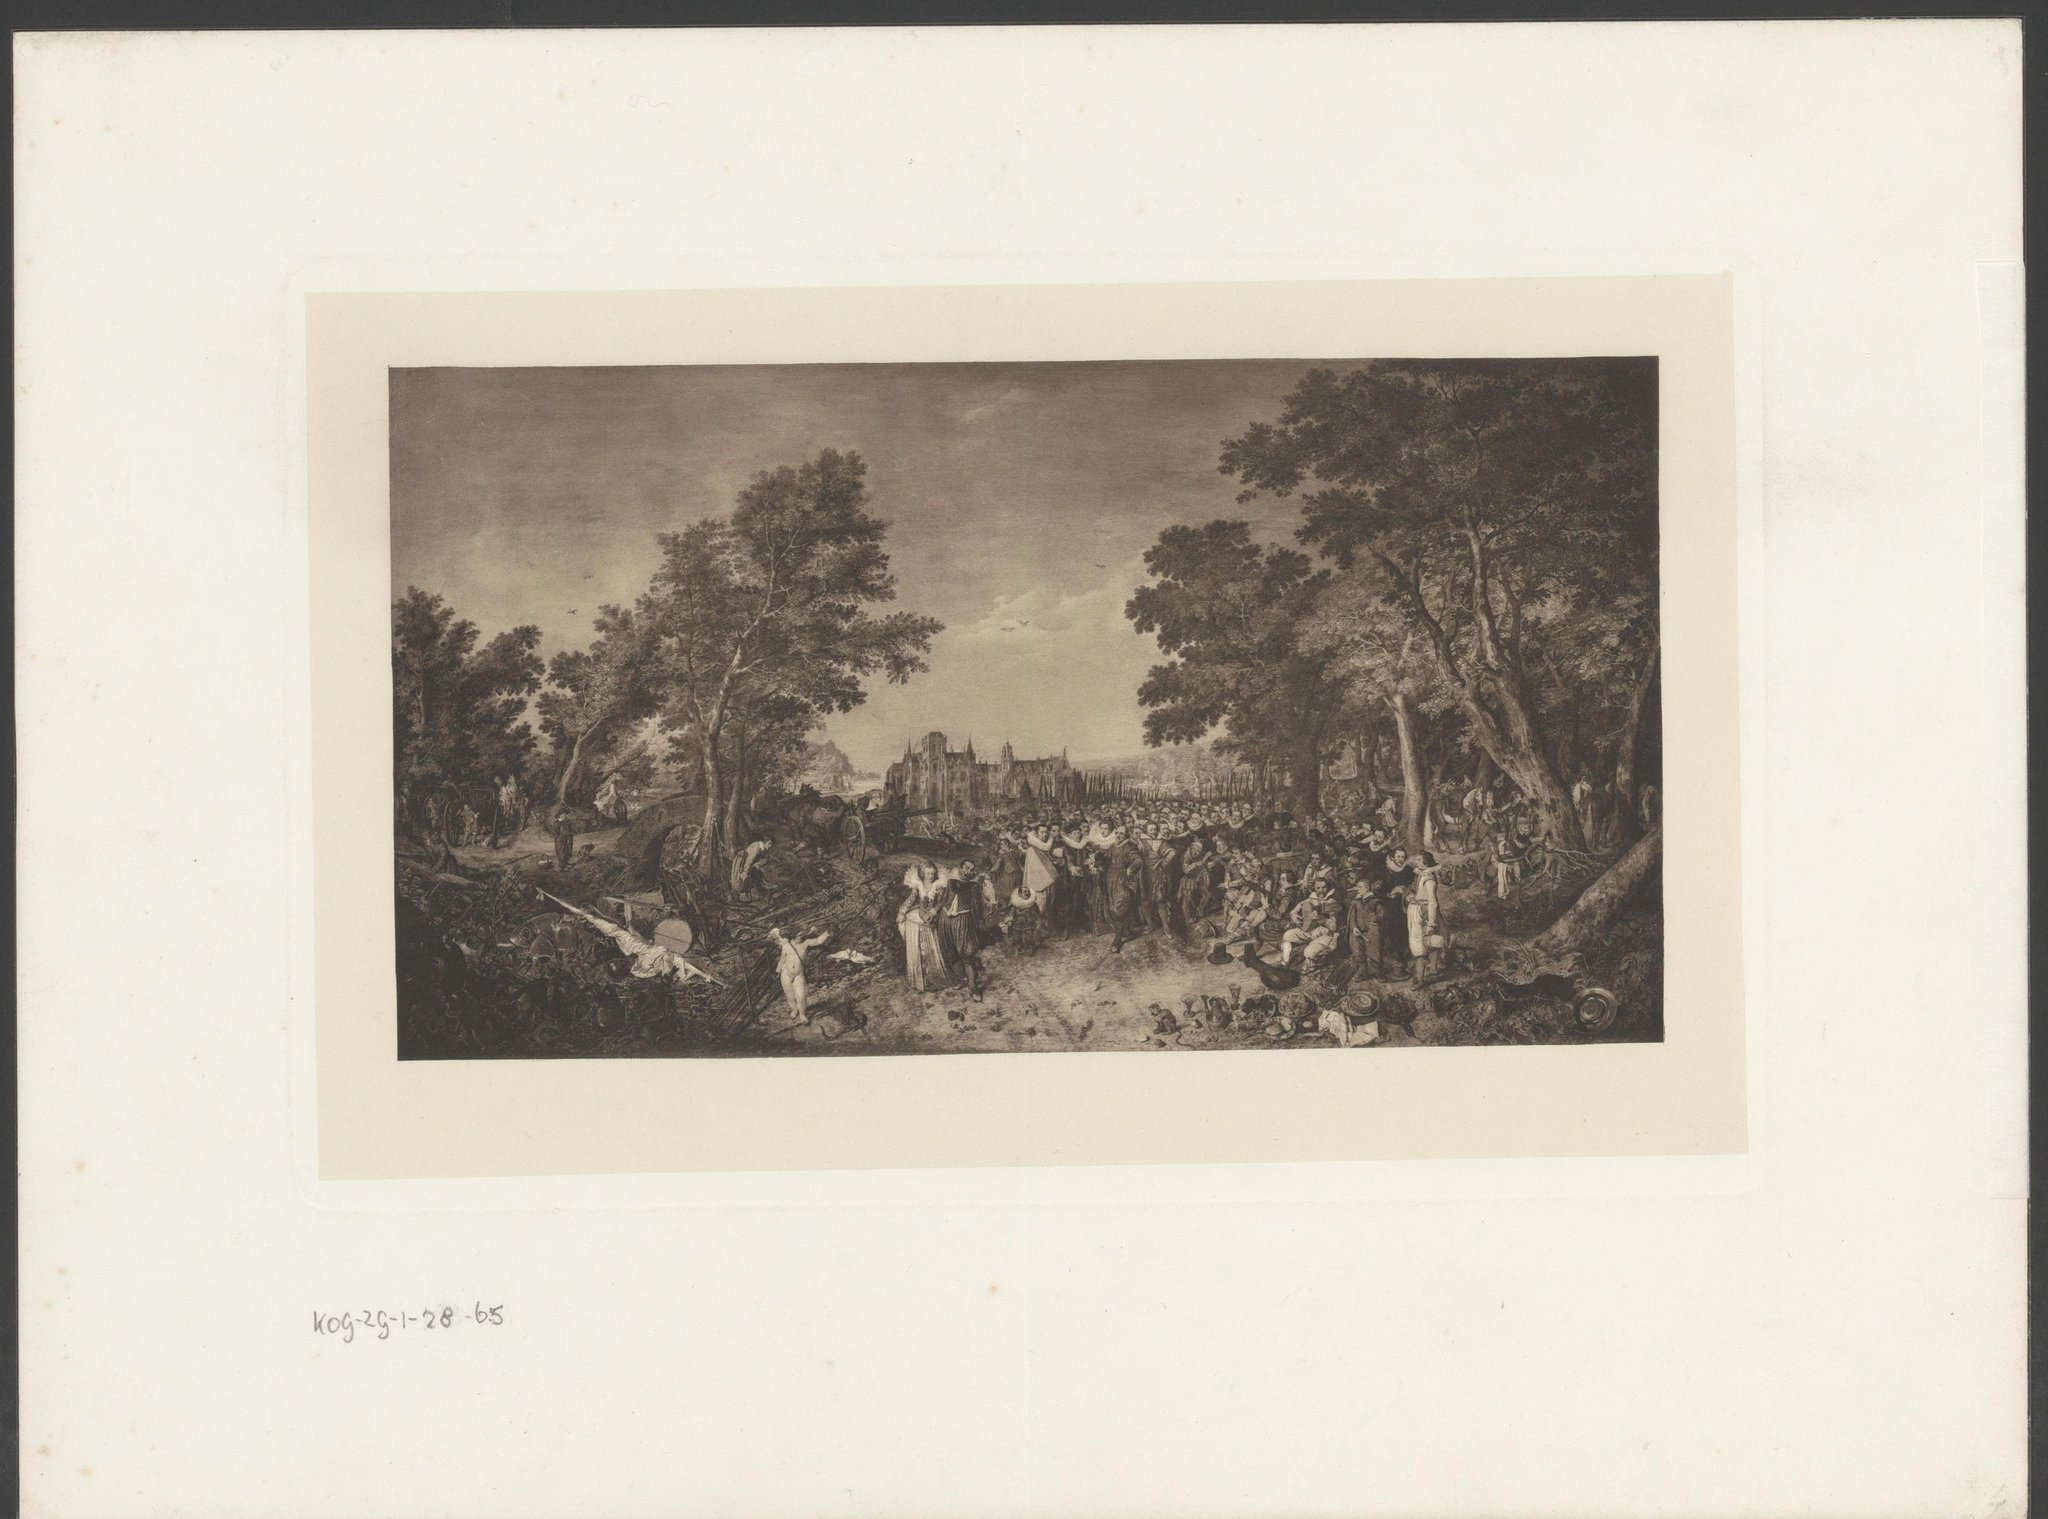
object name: photomechanical print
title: Allegorie op het Twaalfjarig Bestand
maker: Anonymous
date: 1875-1930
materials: paper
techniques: blind stamped, photograph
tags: twaalfjarig bestand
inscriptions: collector's mark: Lugt 1641, stamp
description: Onderwerpsrubrieken binnen de Atlas Zeden en Gewoonten: Zeden en Gewoonten in Engeren Zin. Volksleven. Openbare feesten. Vorstelijke intochten, (Illuminaties, vuurwerken en dergelijke, openbare feesten).